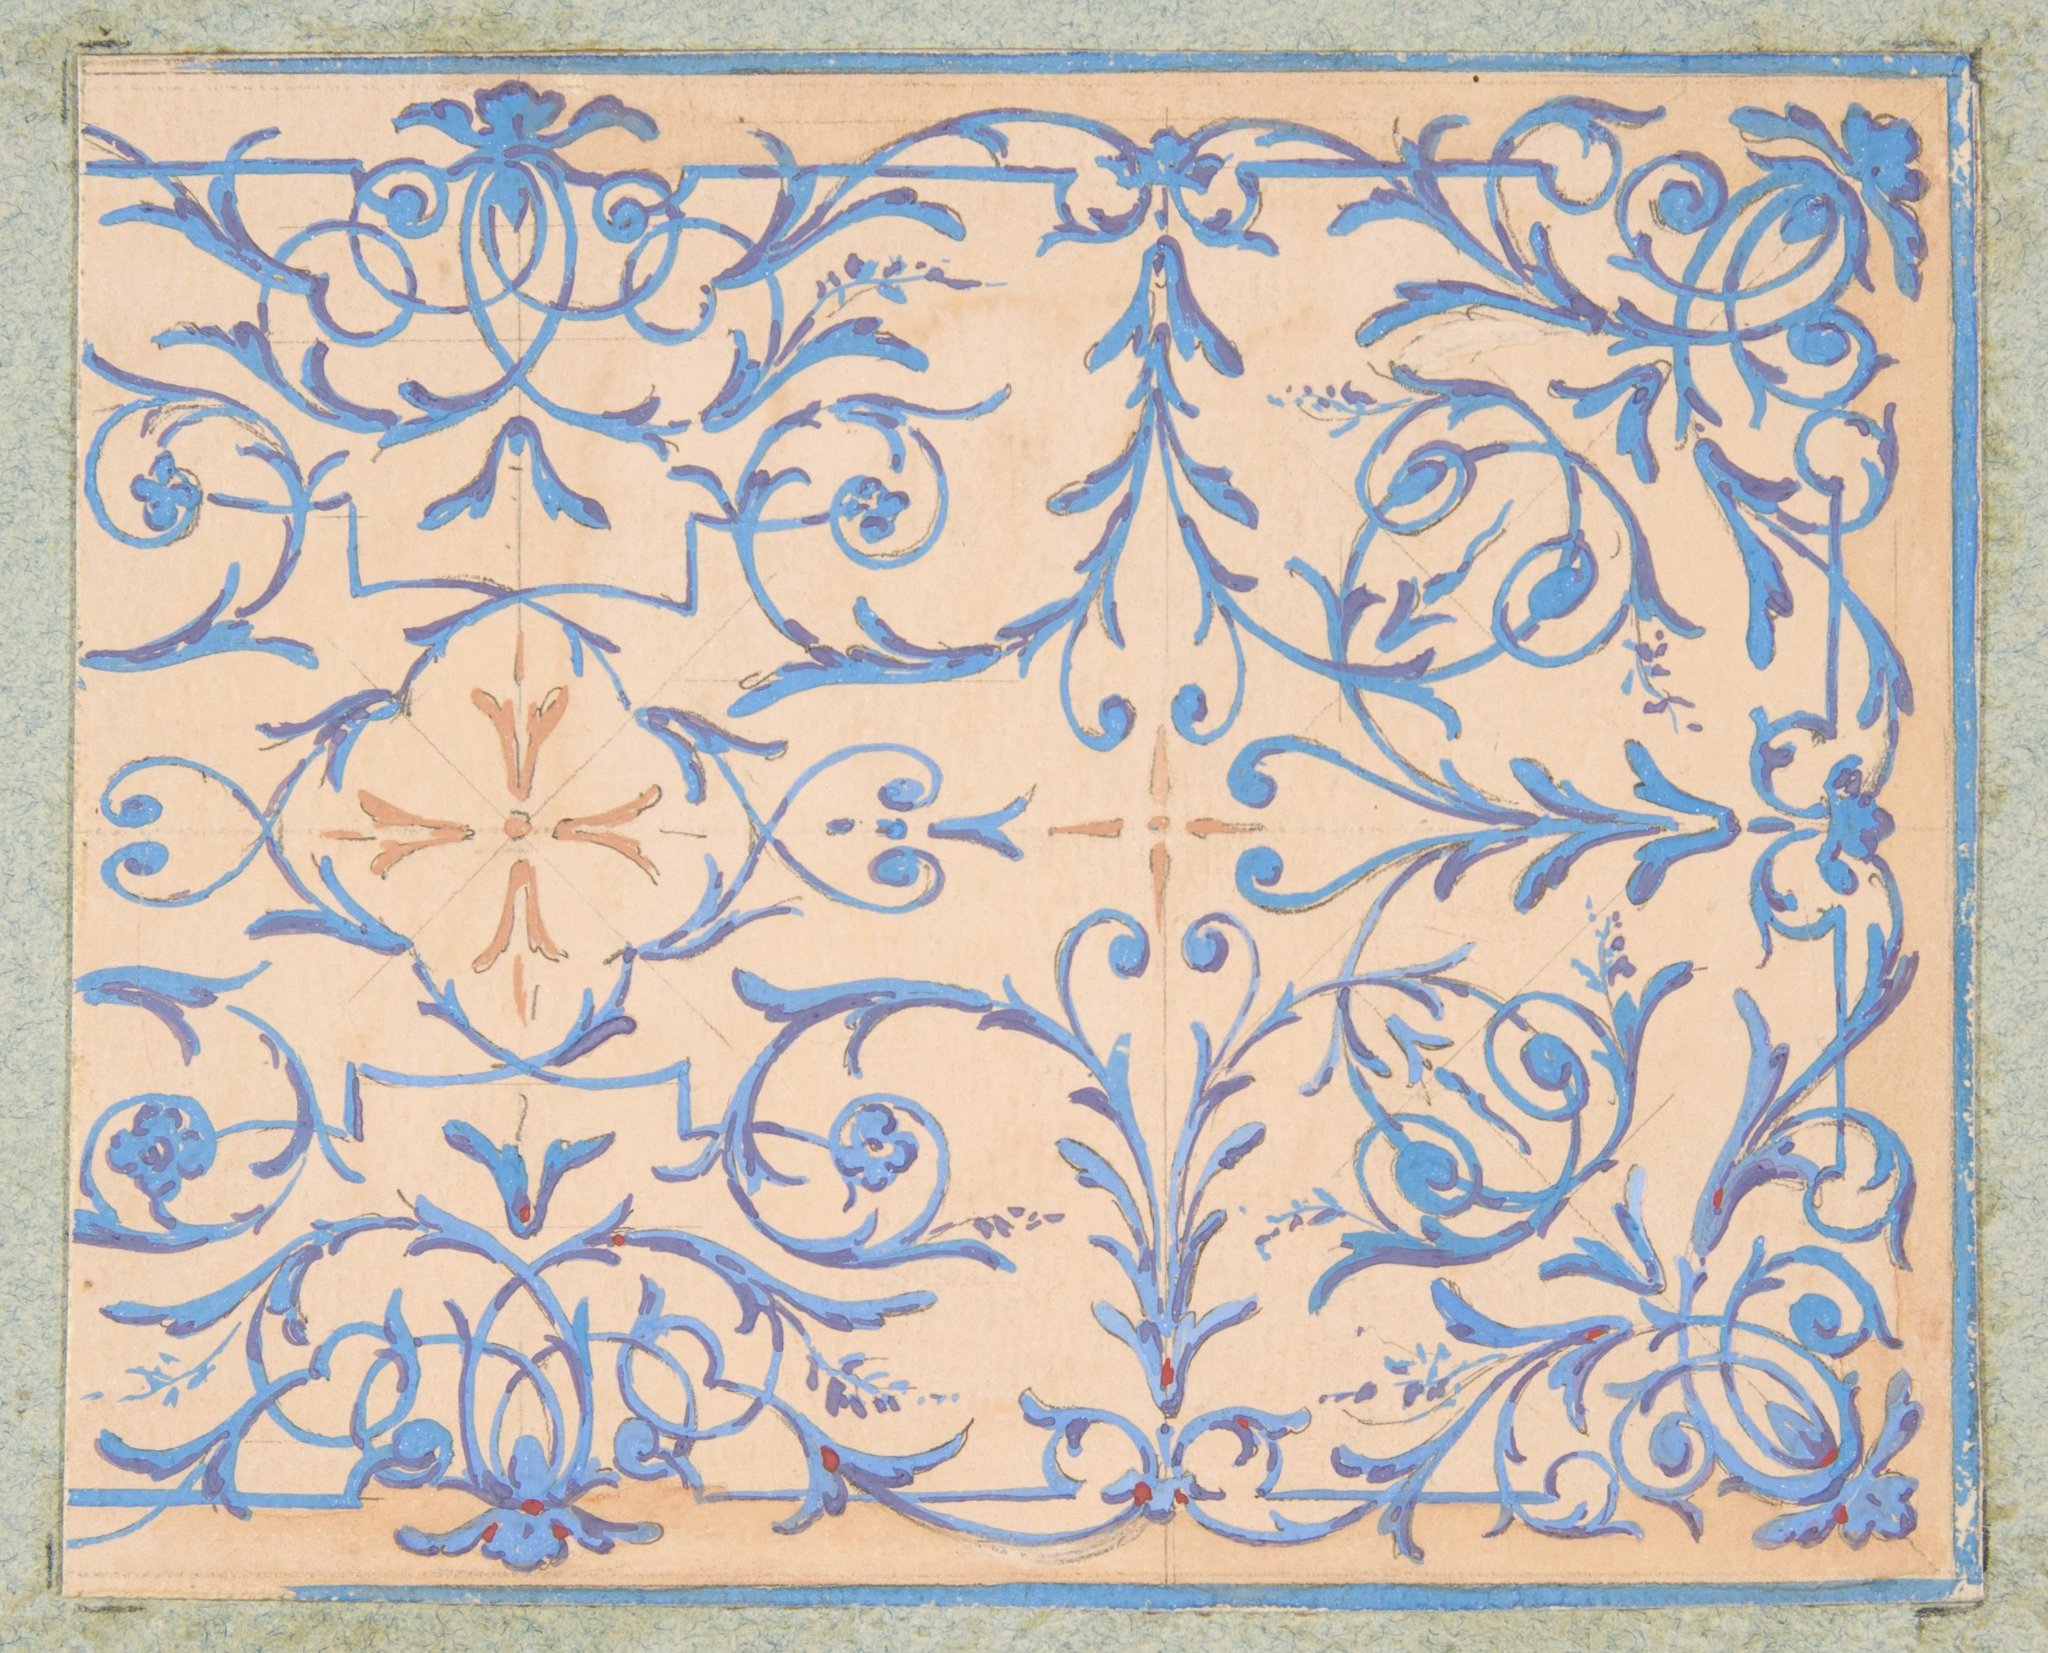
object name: drawing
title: Partial design for a decorative panel painted in rinceaux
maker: jules-edmond-charles lachaise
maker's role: artist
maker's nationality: french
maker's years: 1897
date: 1801-1900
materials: gouache, graphite, paper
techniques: inlay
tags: ornament